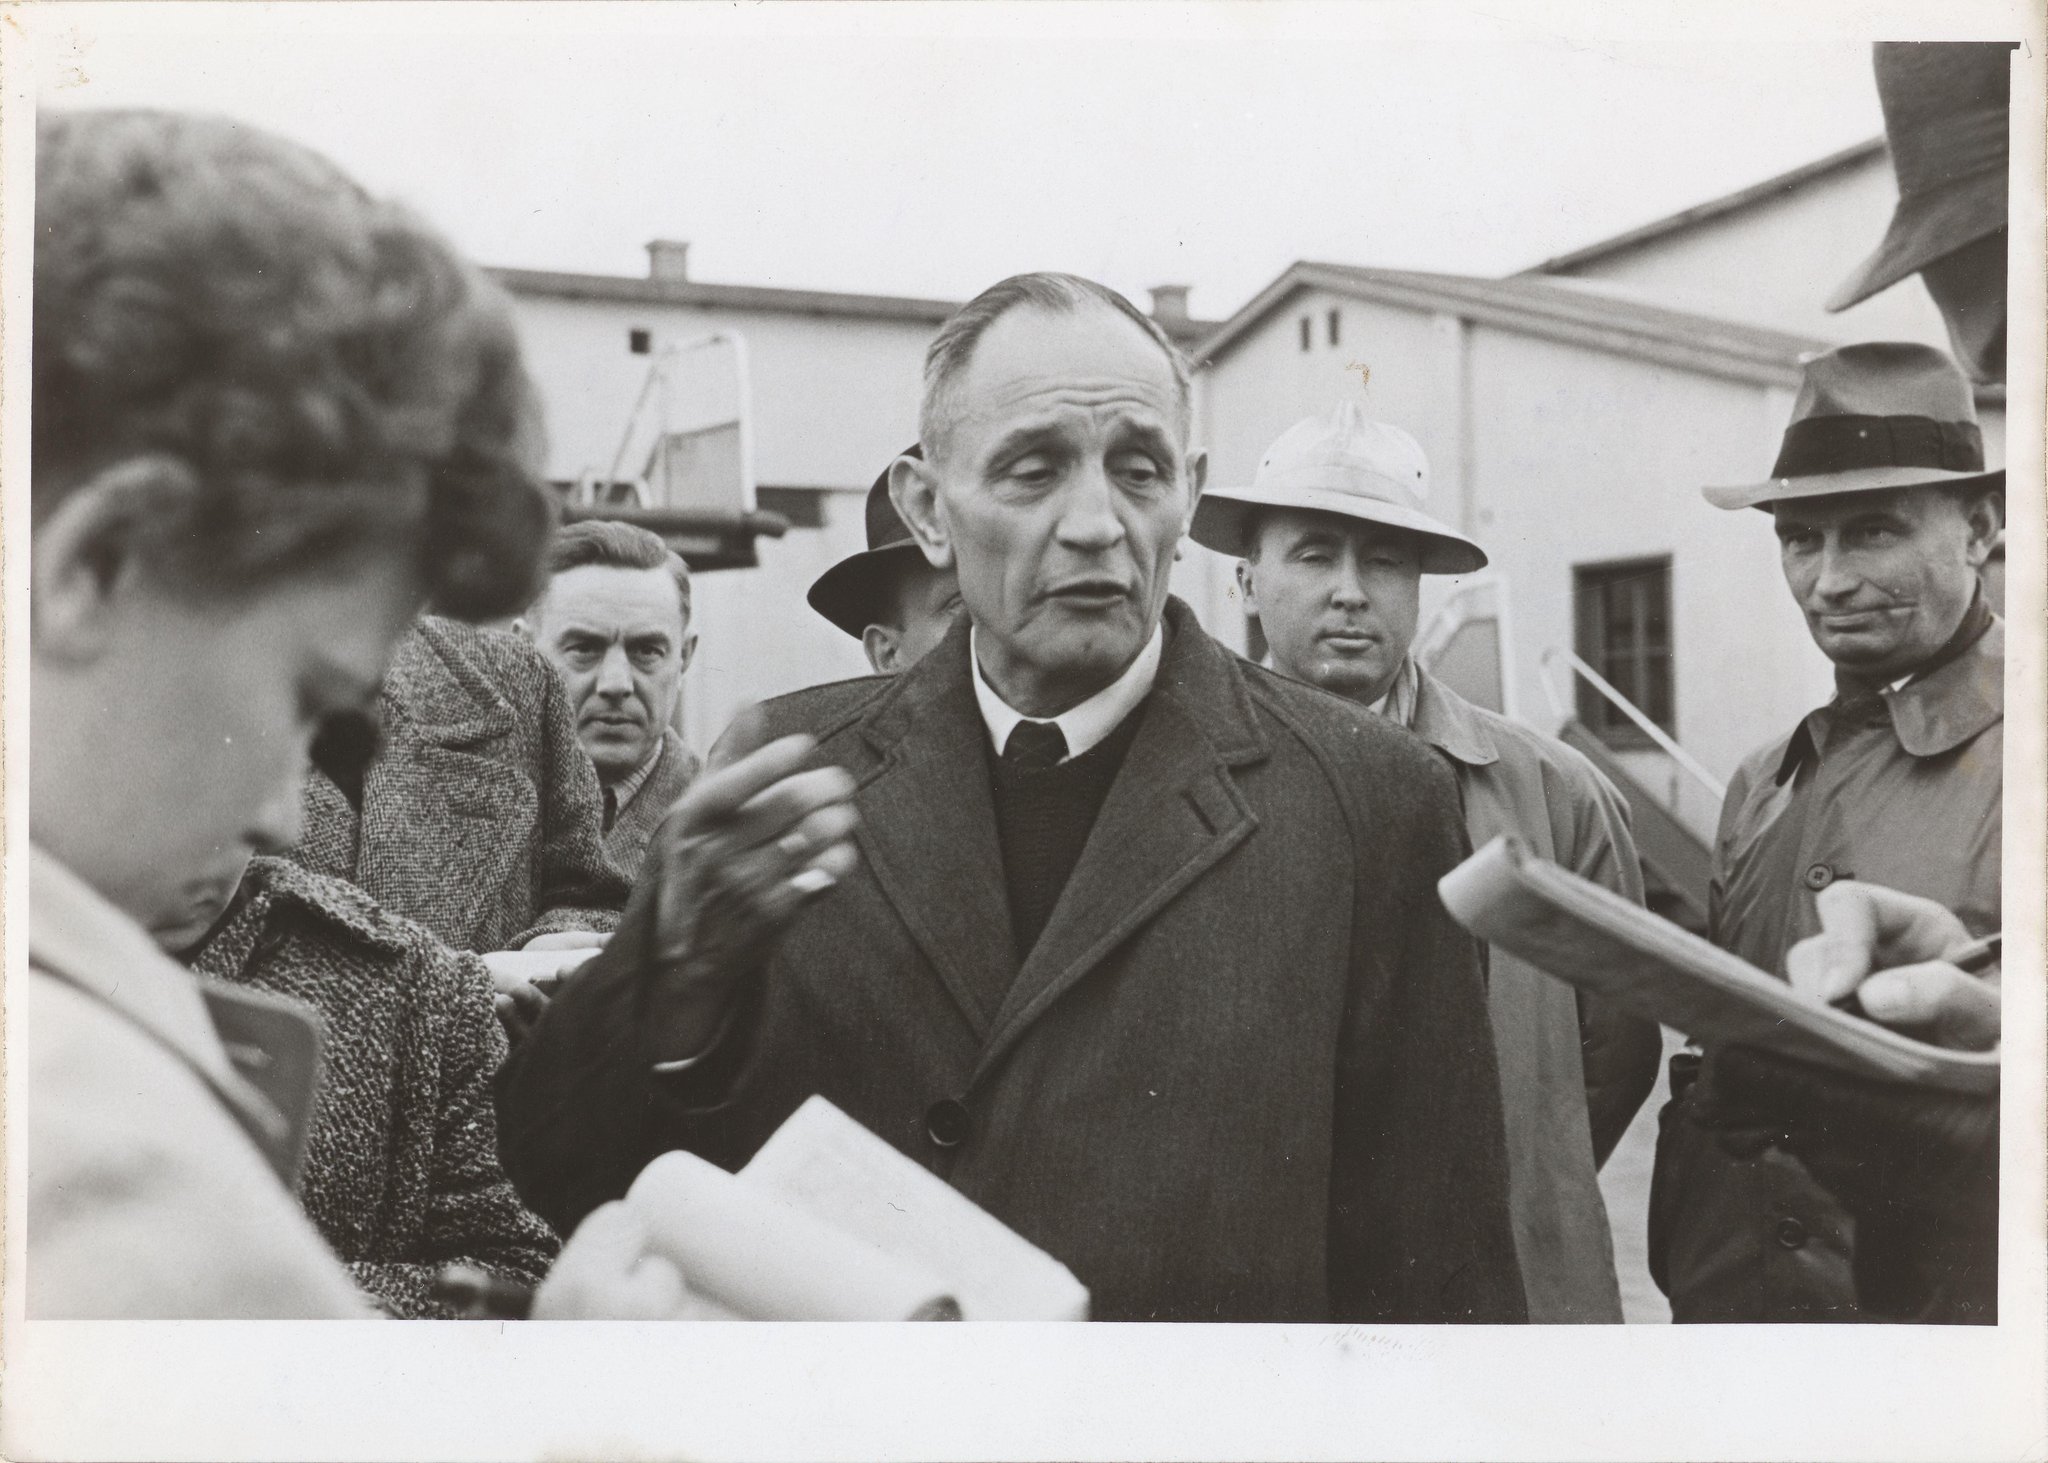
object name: photograph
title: Martin Niemöller na trip naar Australie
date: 1949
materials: photographic support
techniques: gelatin silver print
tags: martin niemöller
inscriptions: stamp: ‘copyright photo press Belgium S.A.’